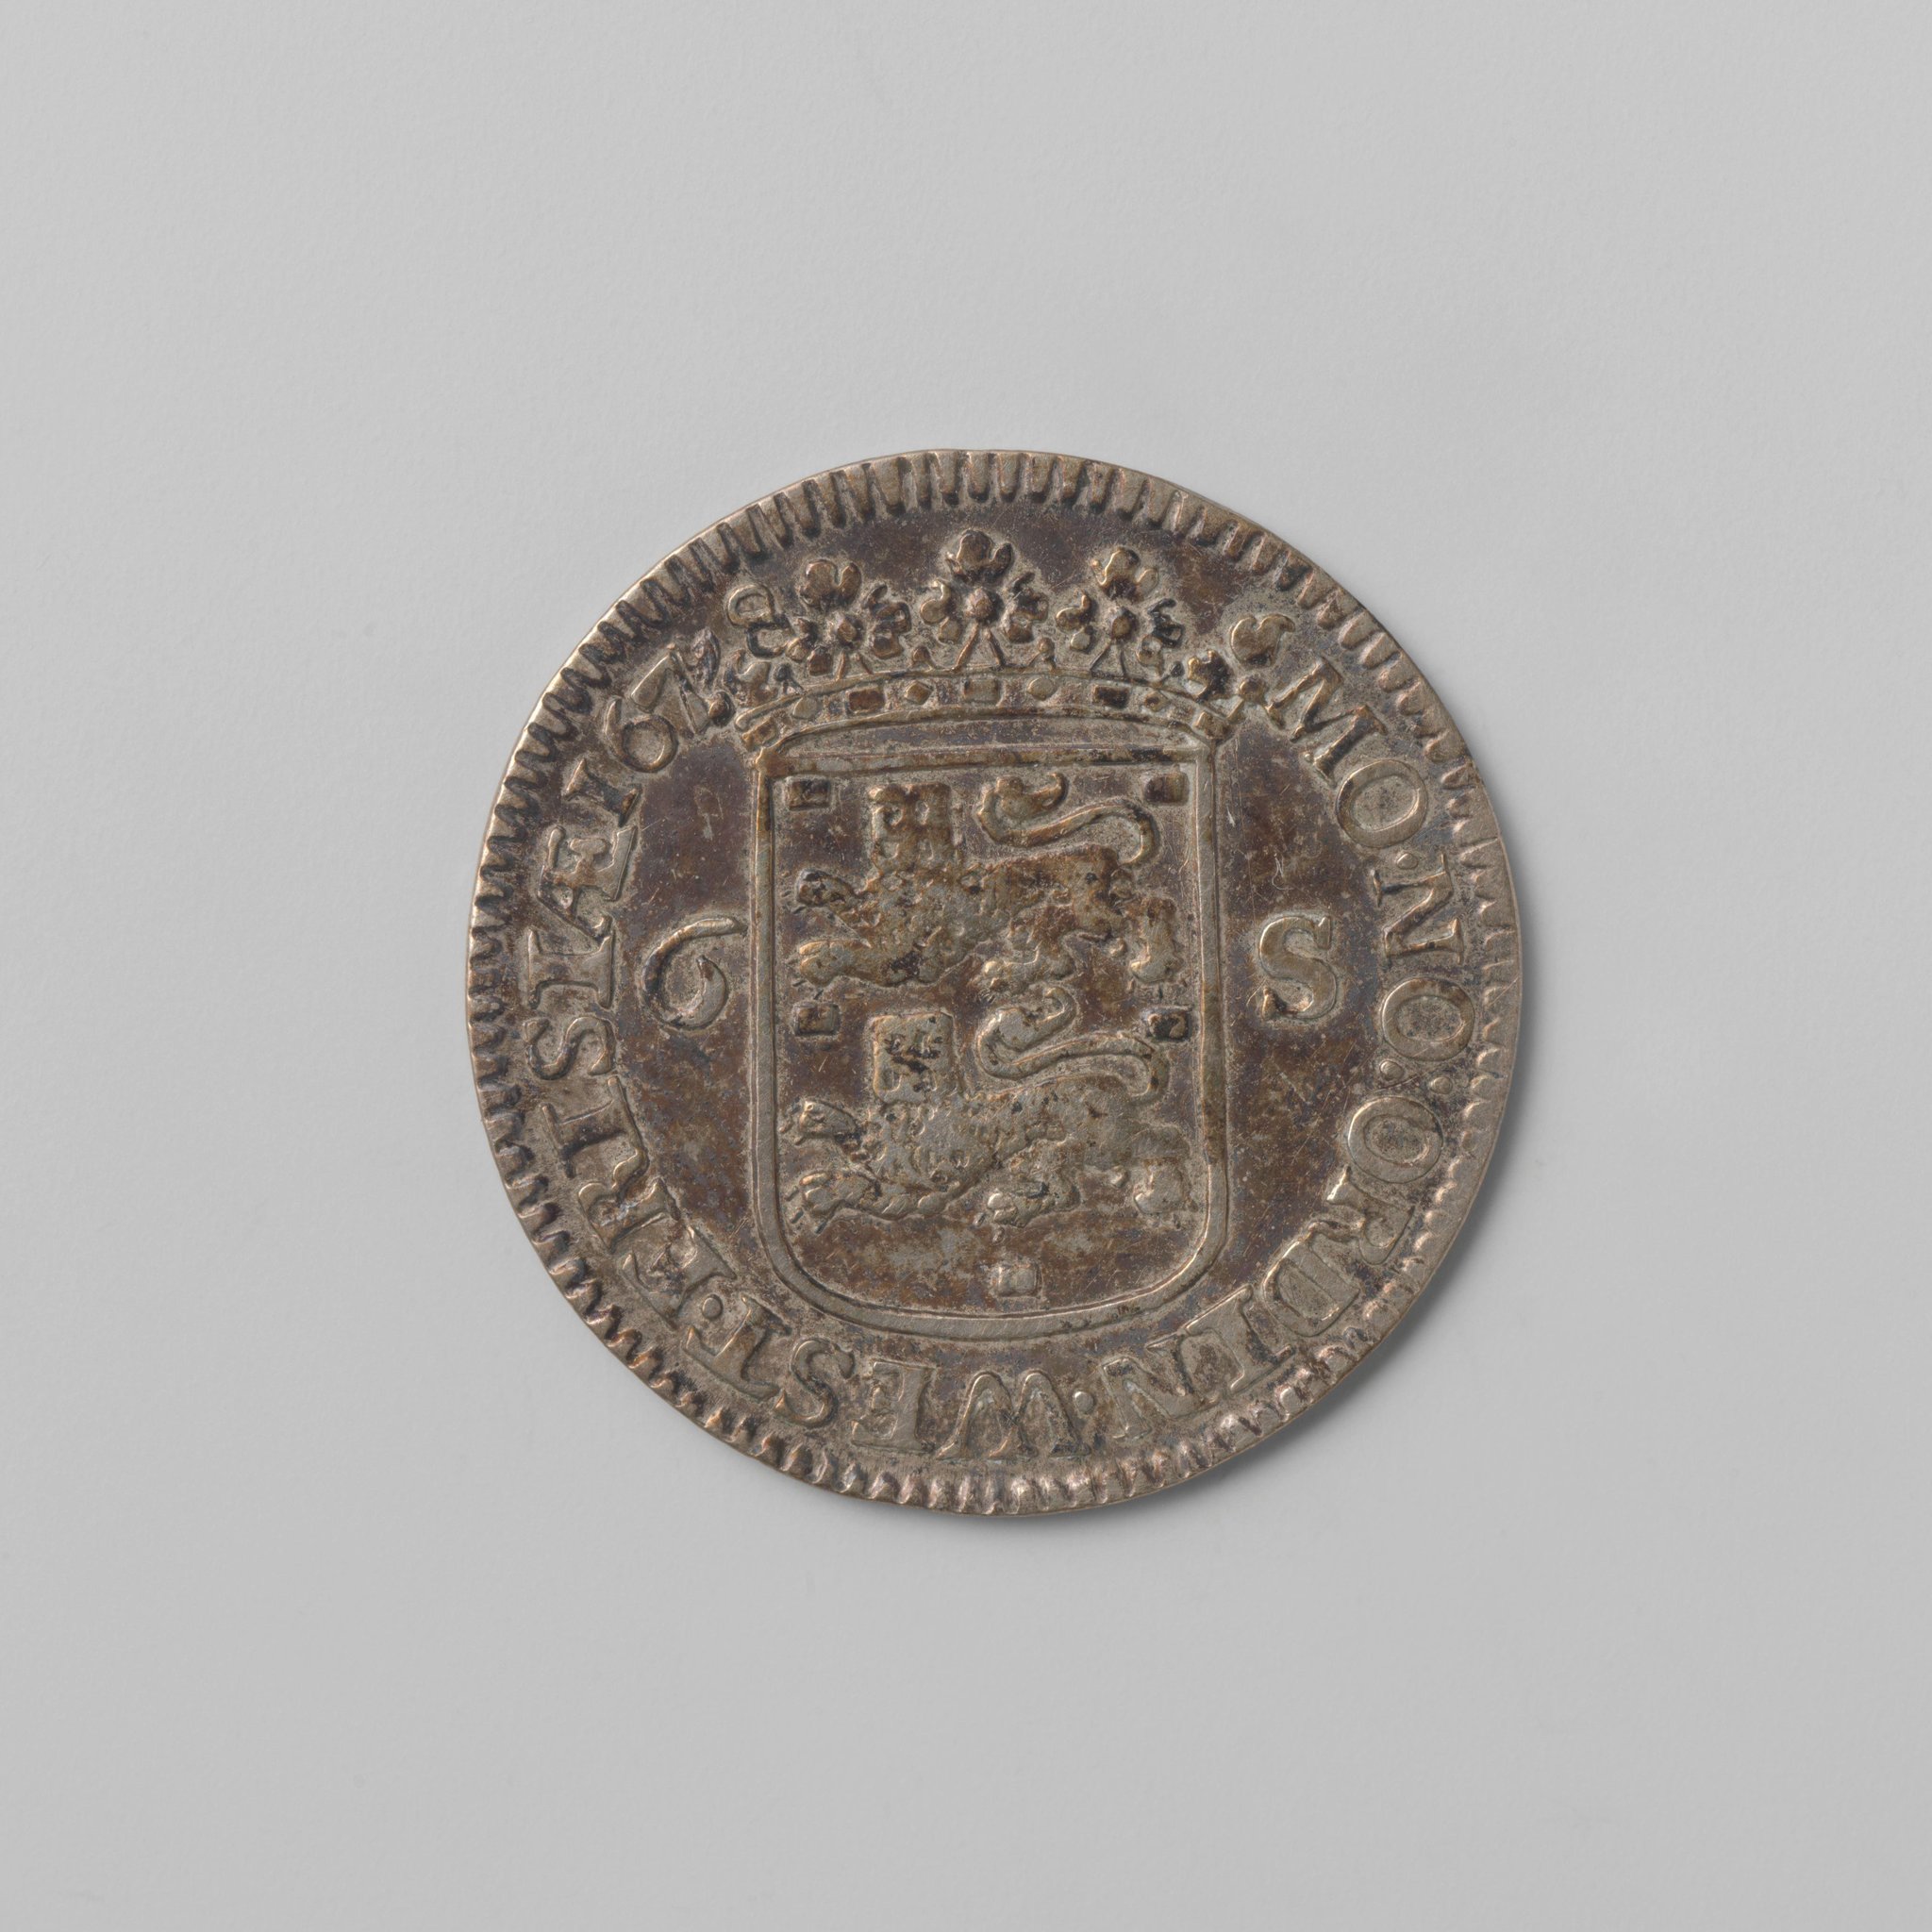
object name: coin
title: West-Friesland, scheepjesschelling, 1678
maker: dirck bosch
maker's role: mintmaster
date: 1678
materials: silver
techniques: striking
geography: enkhuizen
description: Zilveren munt. Voorzijde: tussen waarde-aanduiding 6 S gekroond wapenschild van West-Friesland. Keerzijde: schip met zeilen naar rechts.